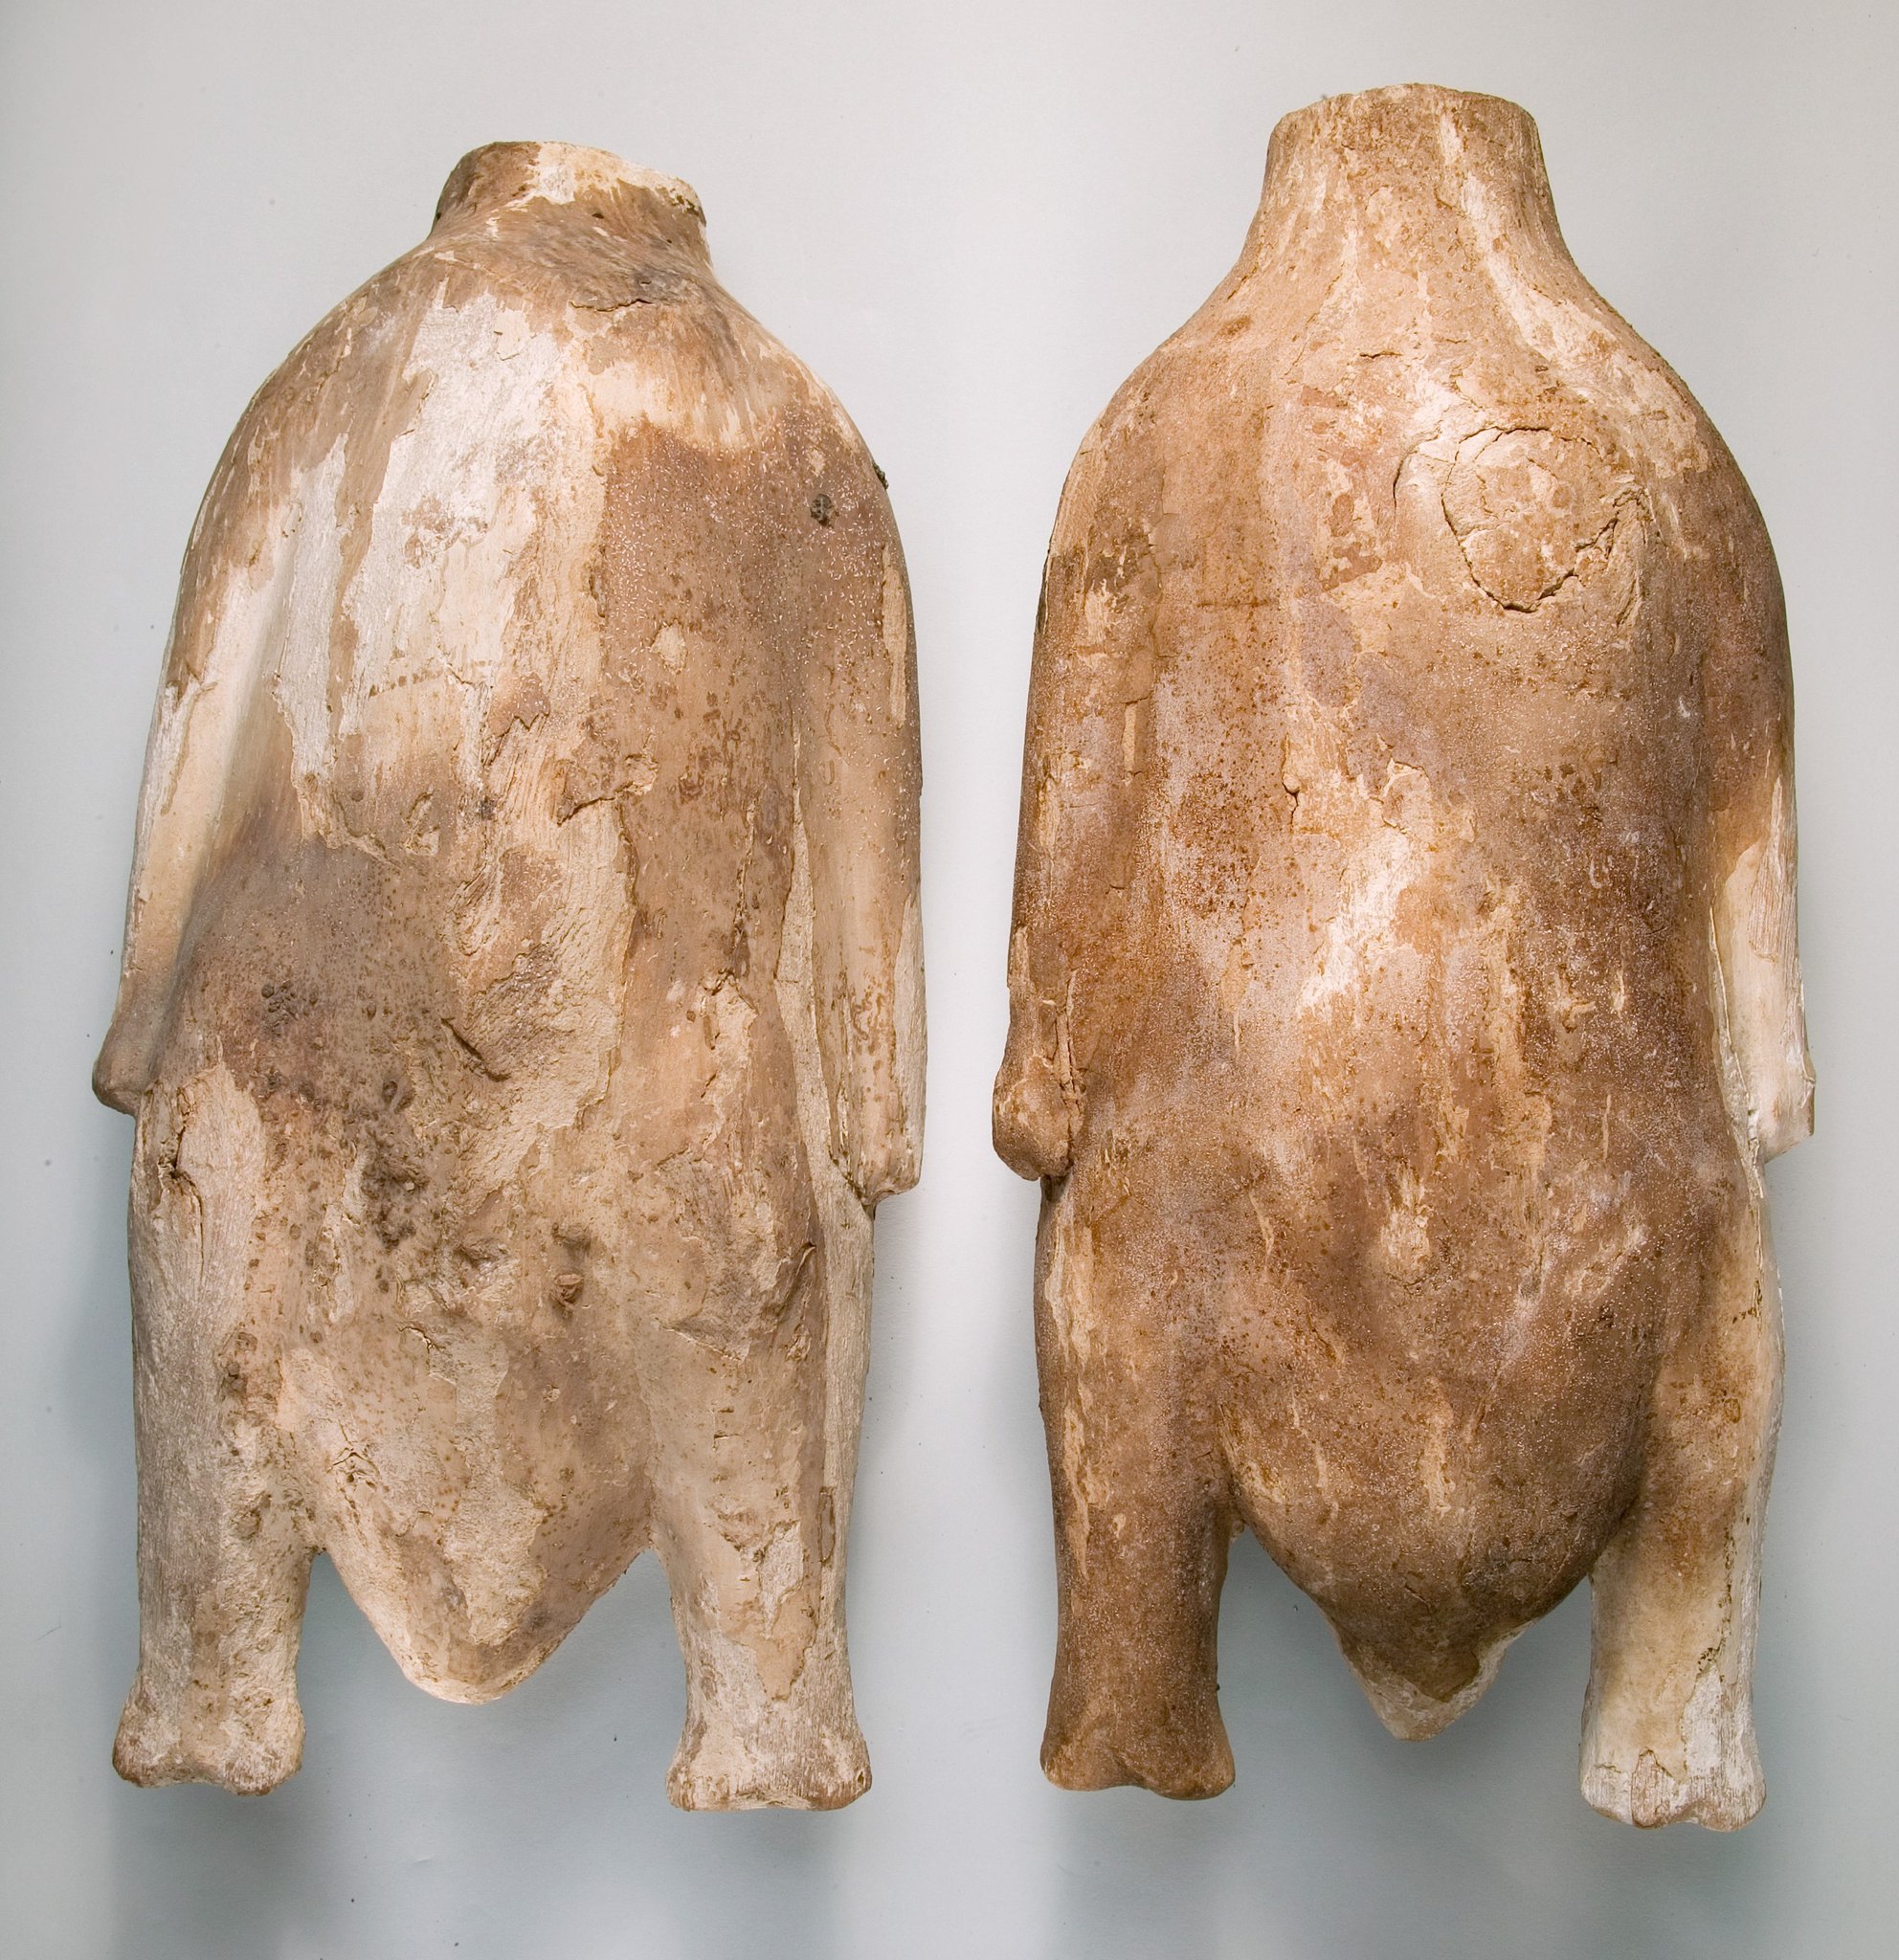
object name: food, case, goose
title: Case for a Goose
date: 1550-1479 BCE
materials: plaster, wood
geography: egypt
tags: geese